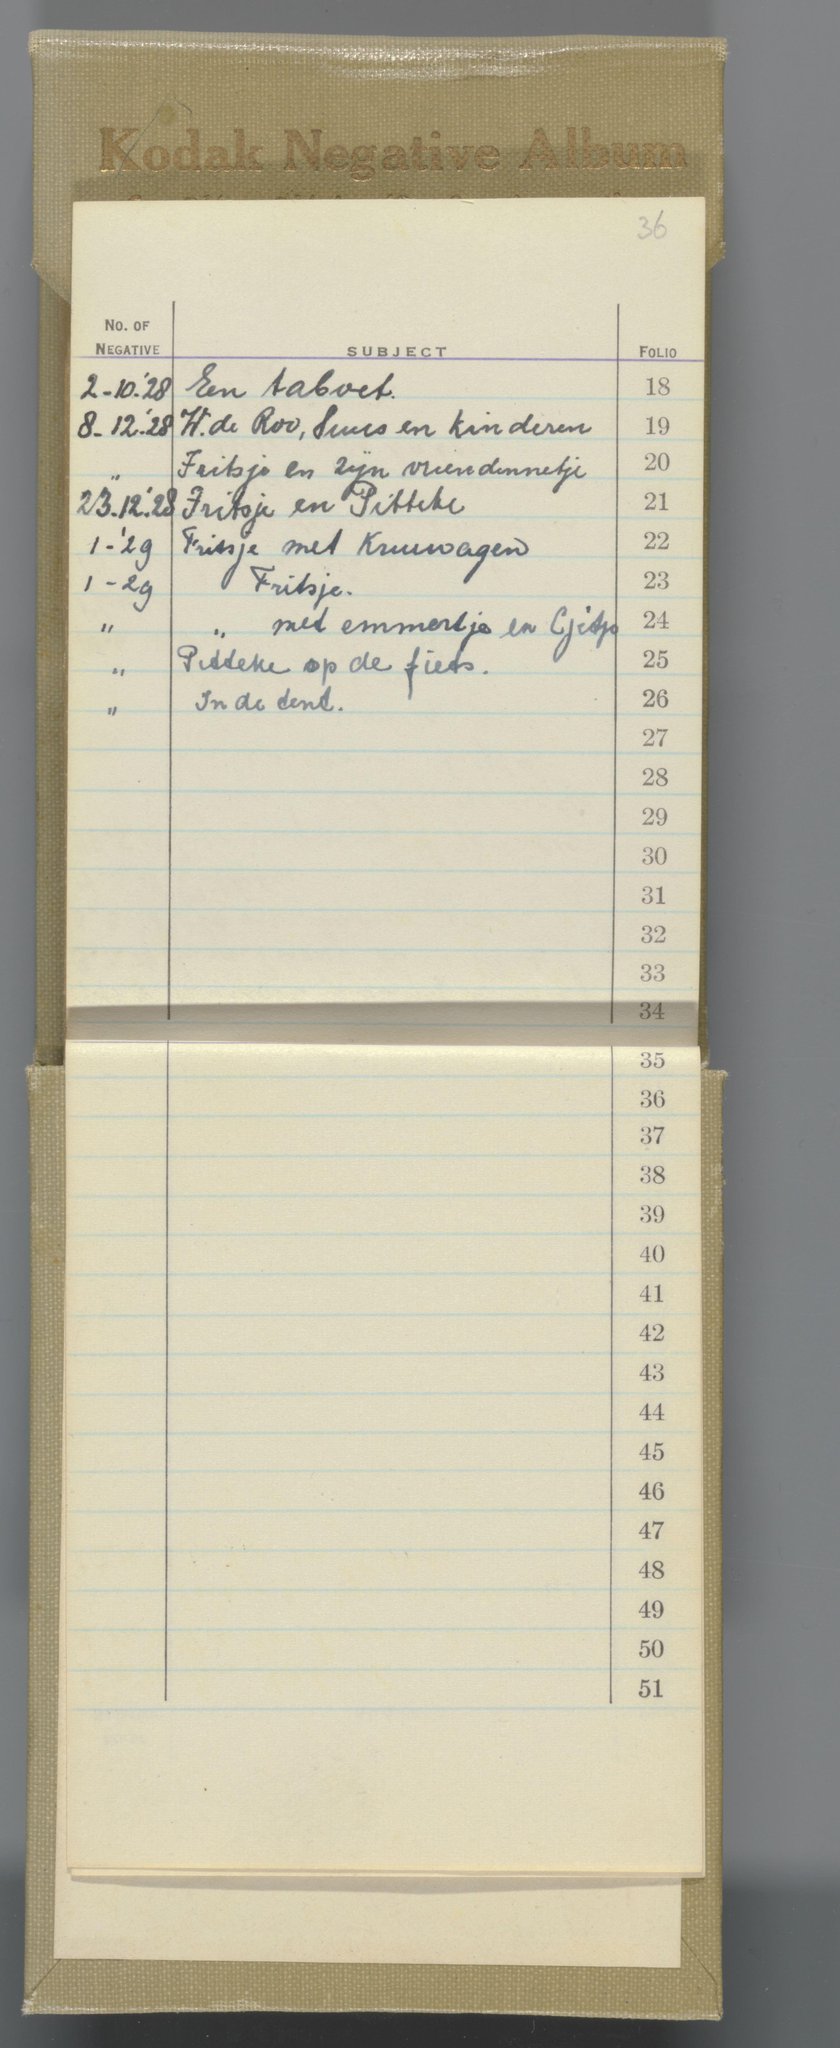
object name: list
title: Lijst met in het album afgebeelde onderwerpen en opnamedatums (18 t/m 26)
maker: Anonymous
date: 1928-1929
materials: paper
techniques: writing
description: Onderdeel van Kodak negatievenalbum met 35 foto's van een familie in Nederlands-Indië.